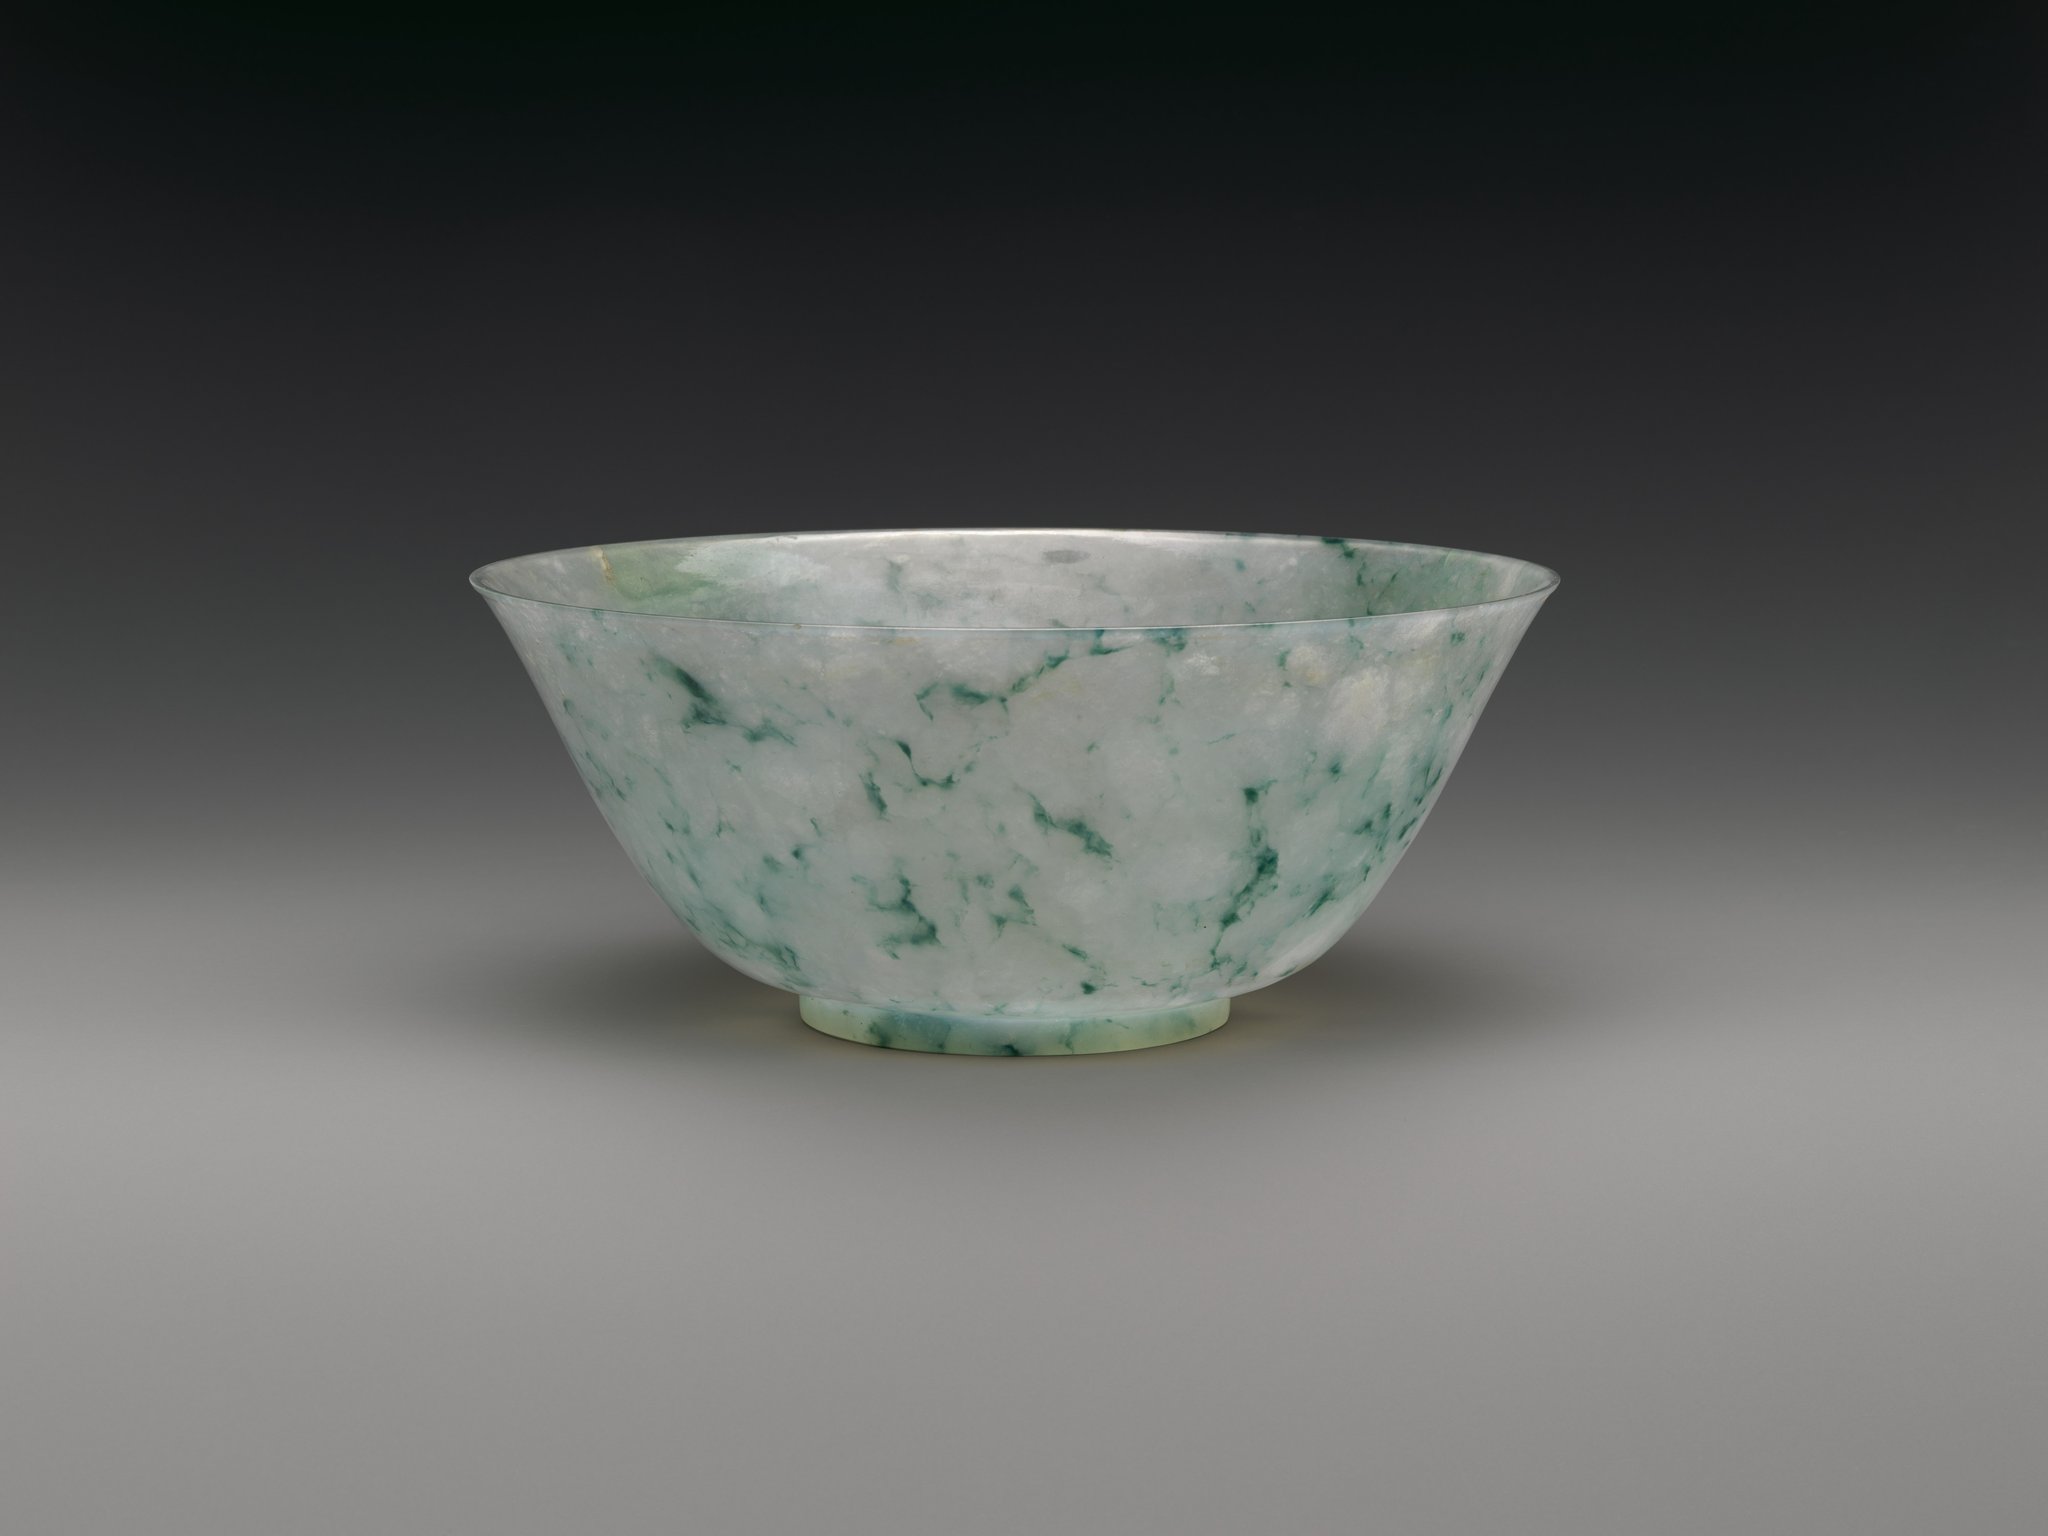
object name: bowl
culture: chinese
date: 1736-1795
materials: jade